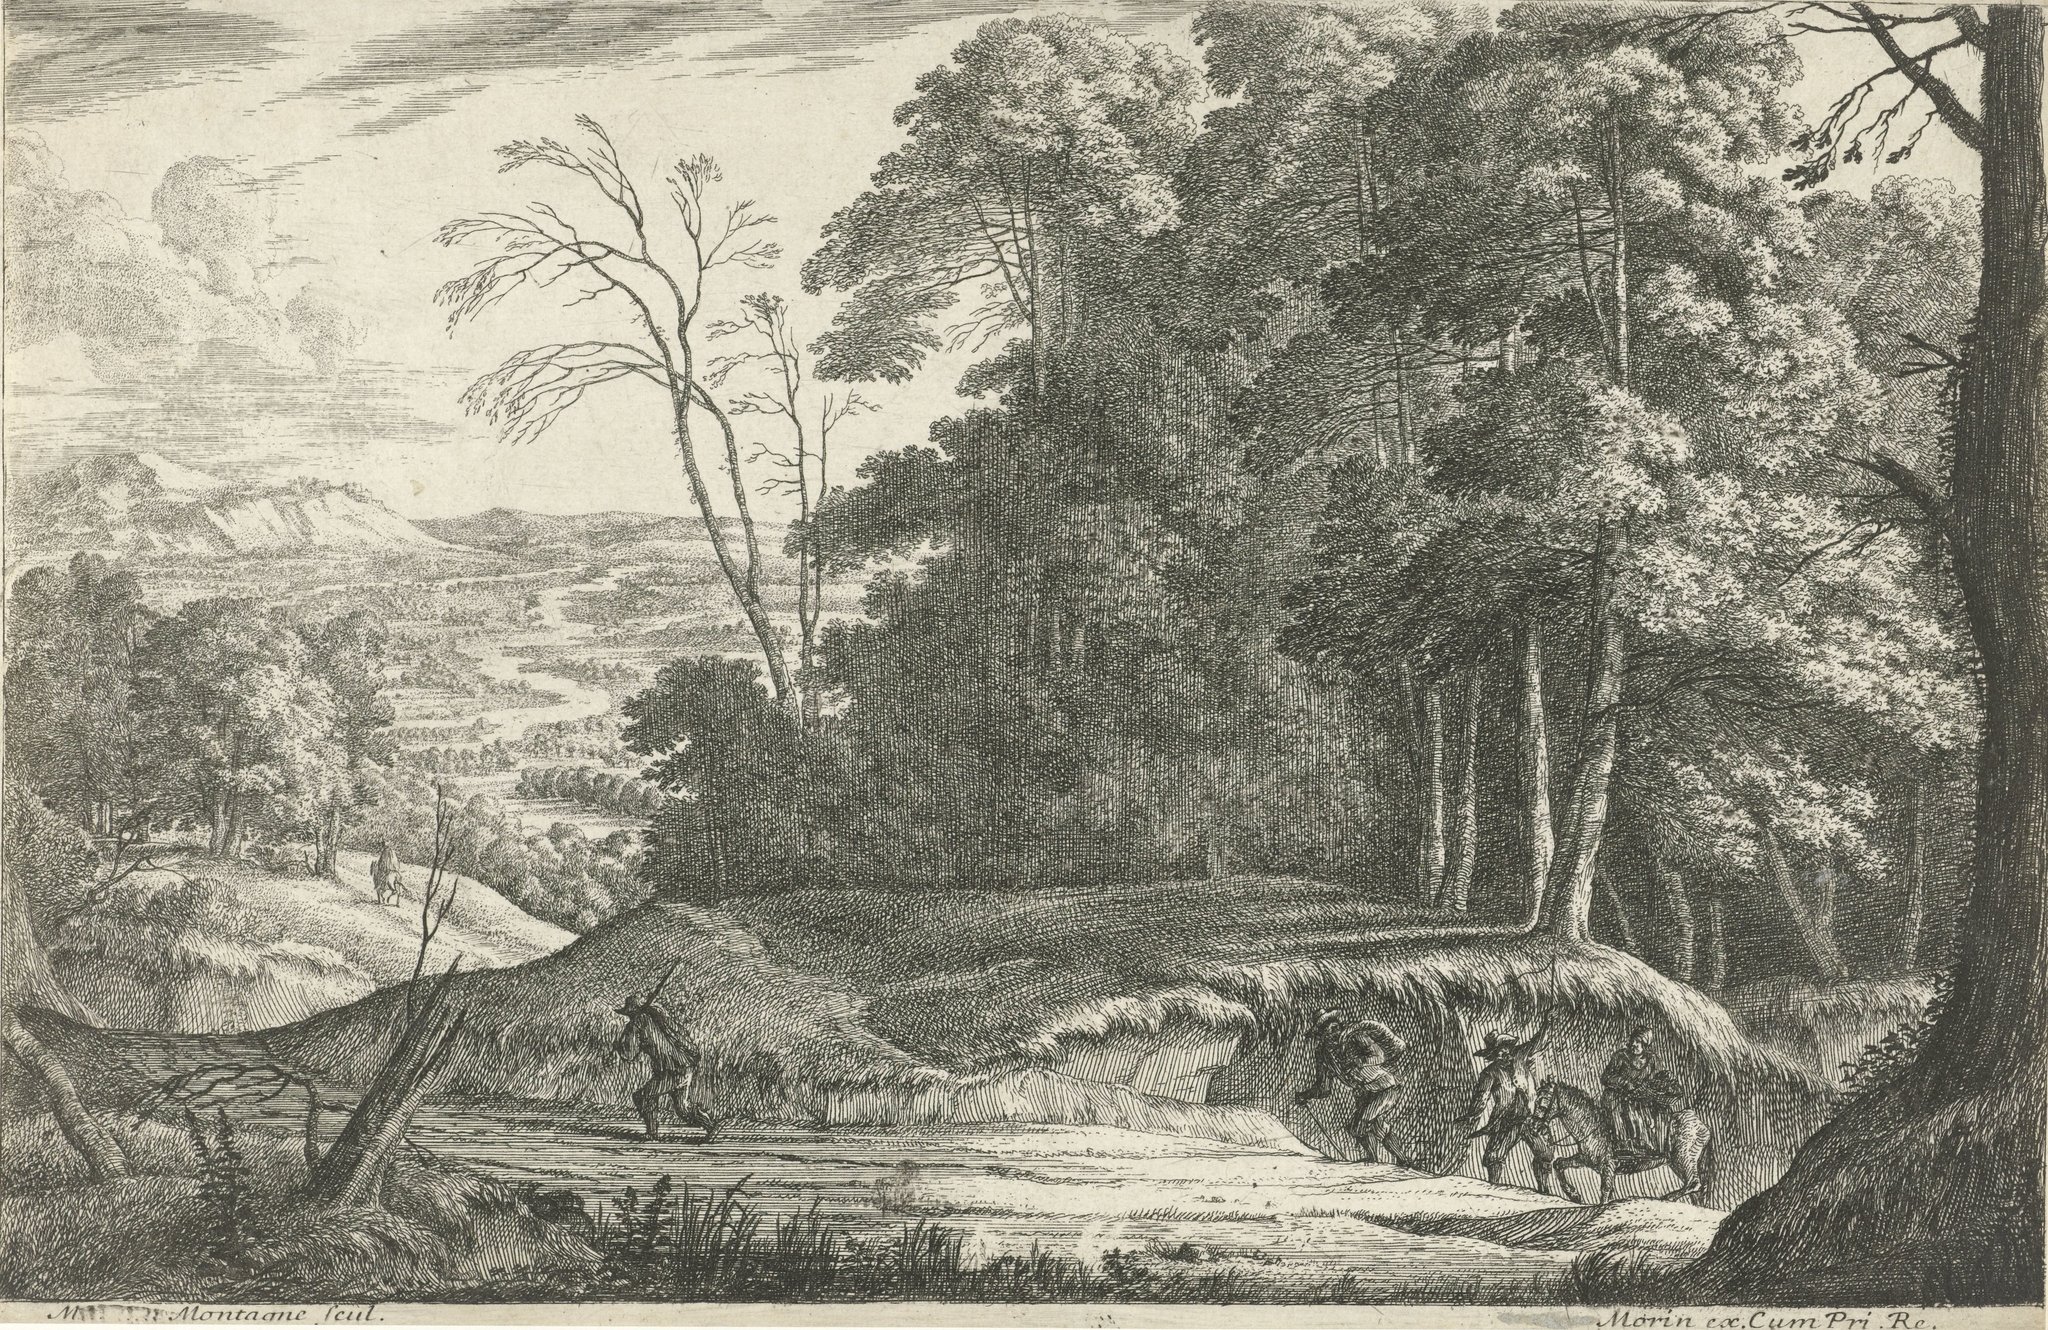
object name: print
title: De weg langs de rand van het bos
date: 1617-1660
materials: paper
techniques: etching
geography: paris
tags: forest path or lane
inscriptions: collector's mark: Lugt 2228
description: Reizigers wandelen over een pad langs de rand van het bos. Links op de achtergrond een gezicht op heuvelachtig landschap.